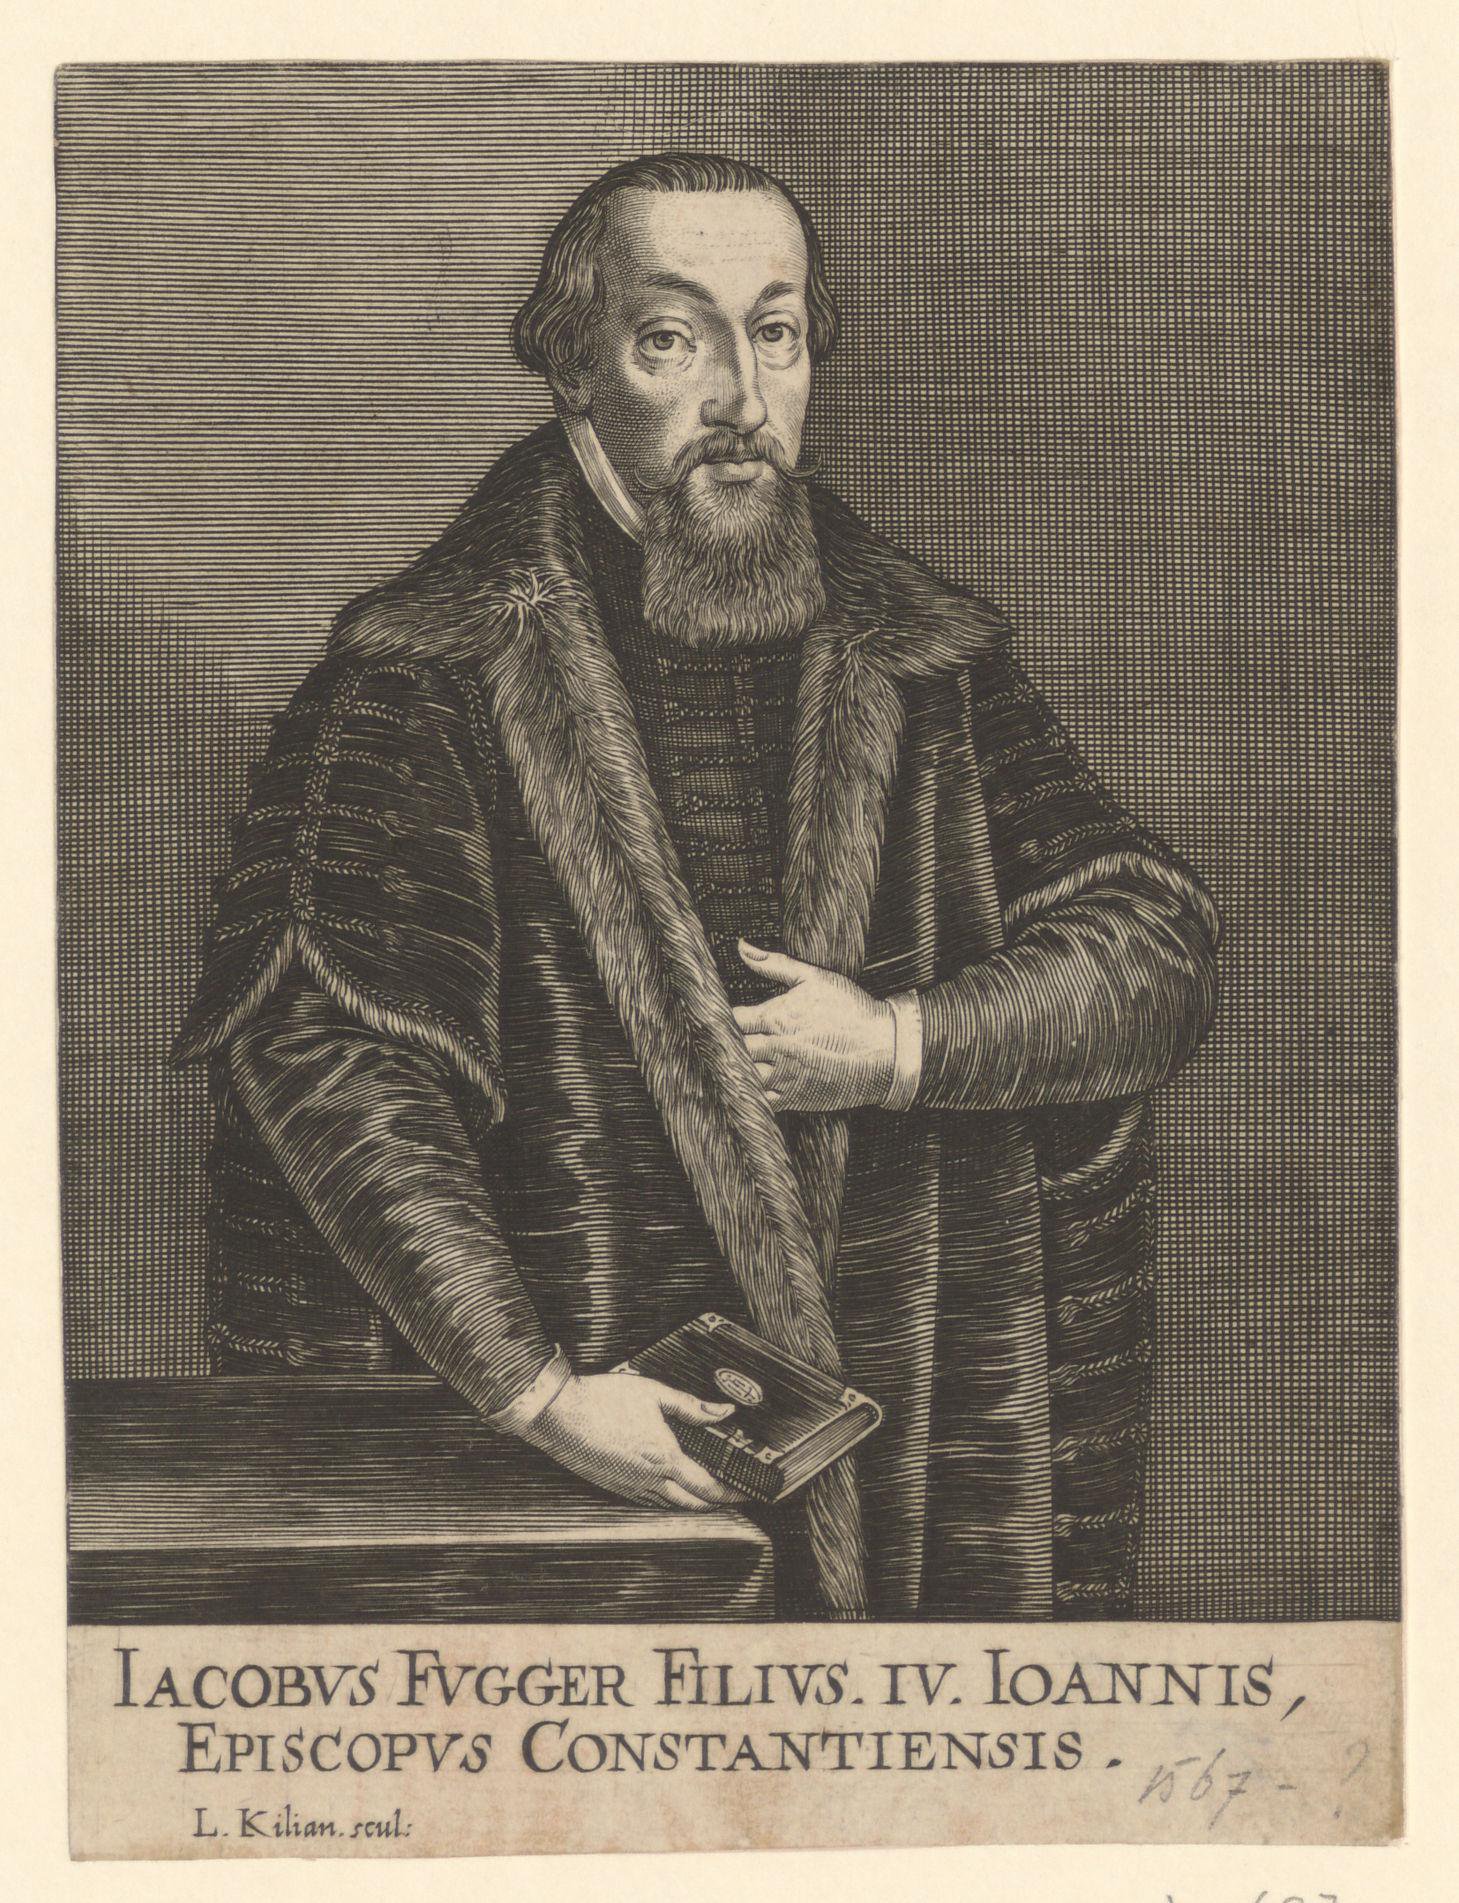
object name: print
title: Portret van Jakob Fugger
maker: lucas kilian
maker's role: draughtsman, print maker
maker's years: 1579-1637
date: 1589-1620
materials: paper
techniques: engraving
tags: coat of arms (as symbol of the state, etc.), archbishop, bishop, etc. (roman catholic), historical persons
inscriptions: collector's mark: Lugt 2228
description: Prent mogelijk gebruikt in: Kilian, Lucas en Kilian, Wolfgang. Contrafehe Der Herrn Fugger und Frawen Fuggerin (...) welche in diesen Geslechte geboren wurden, und zu demselben sich ehelich verplichtet haben (...) Anno MDCXX. Augsburg: Wolfgang Kilian, 1620.